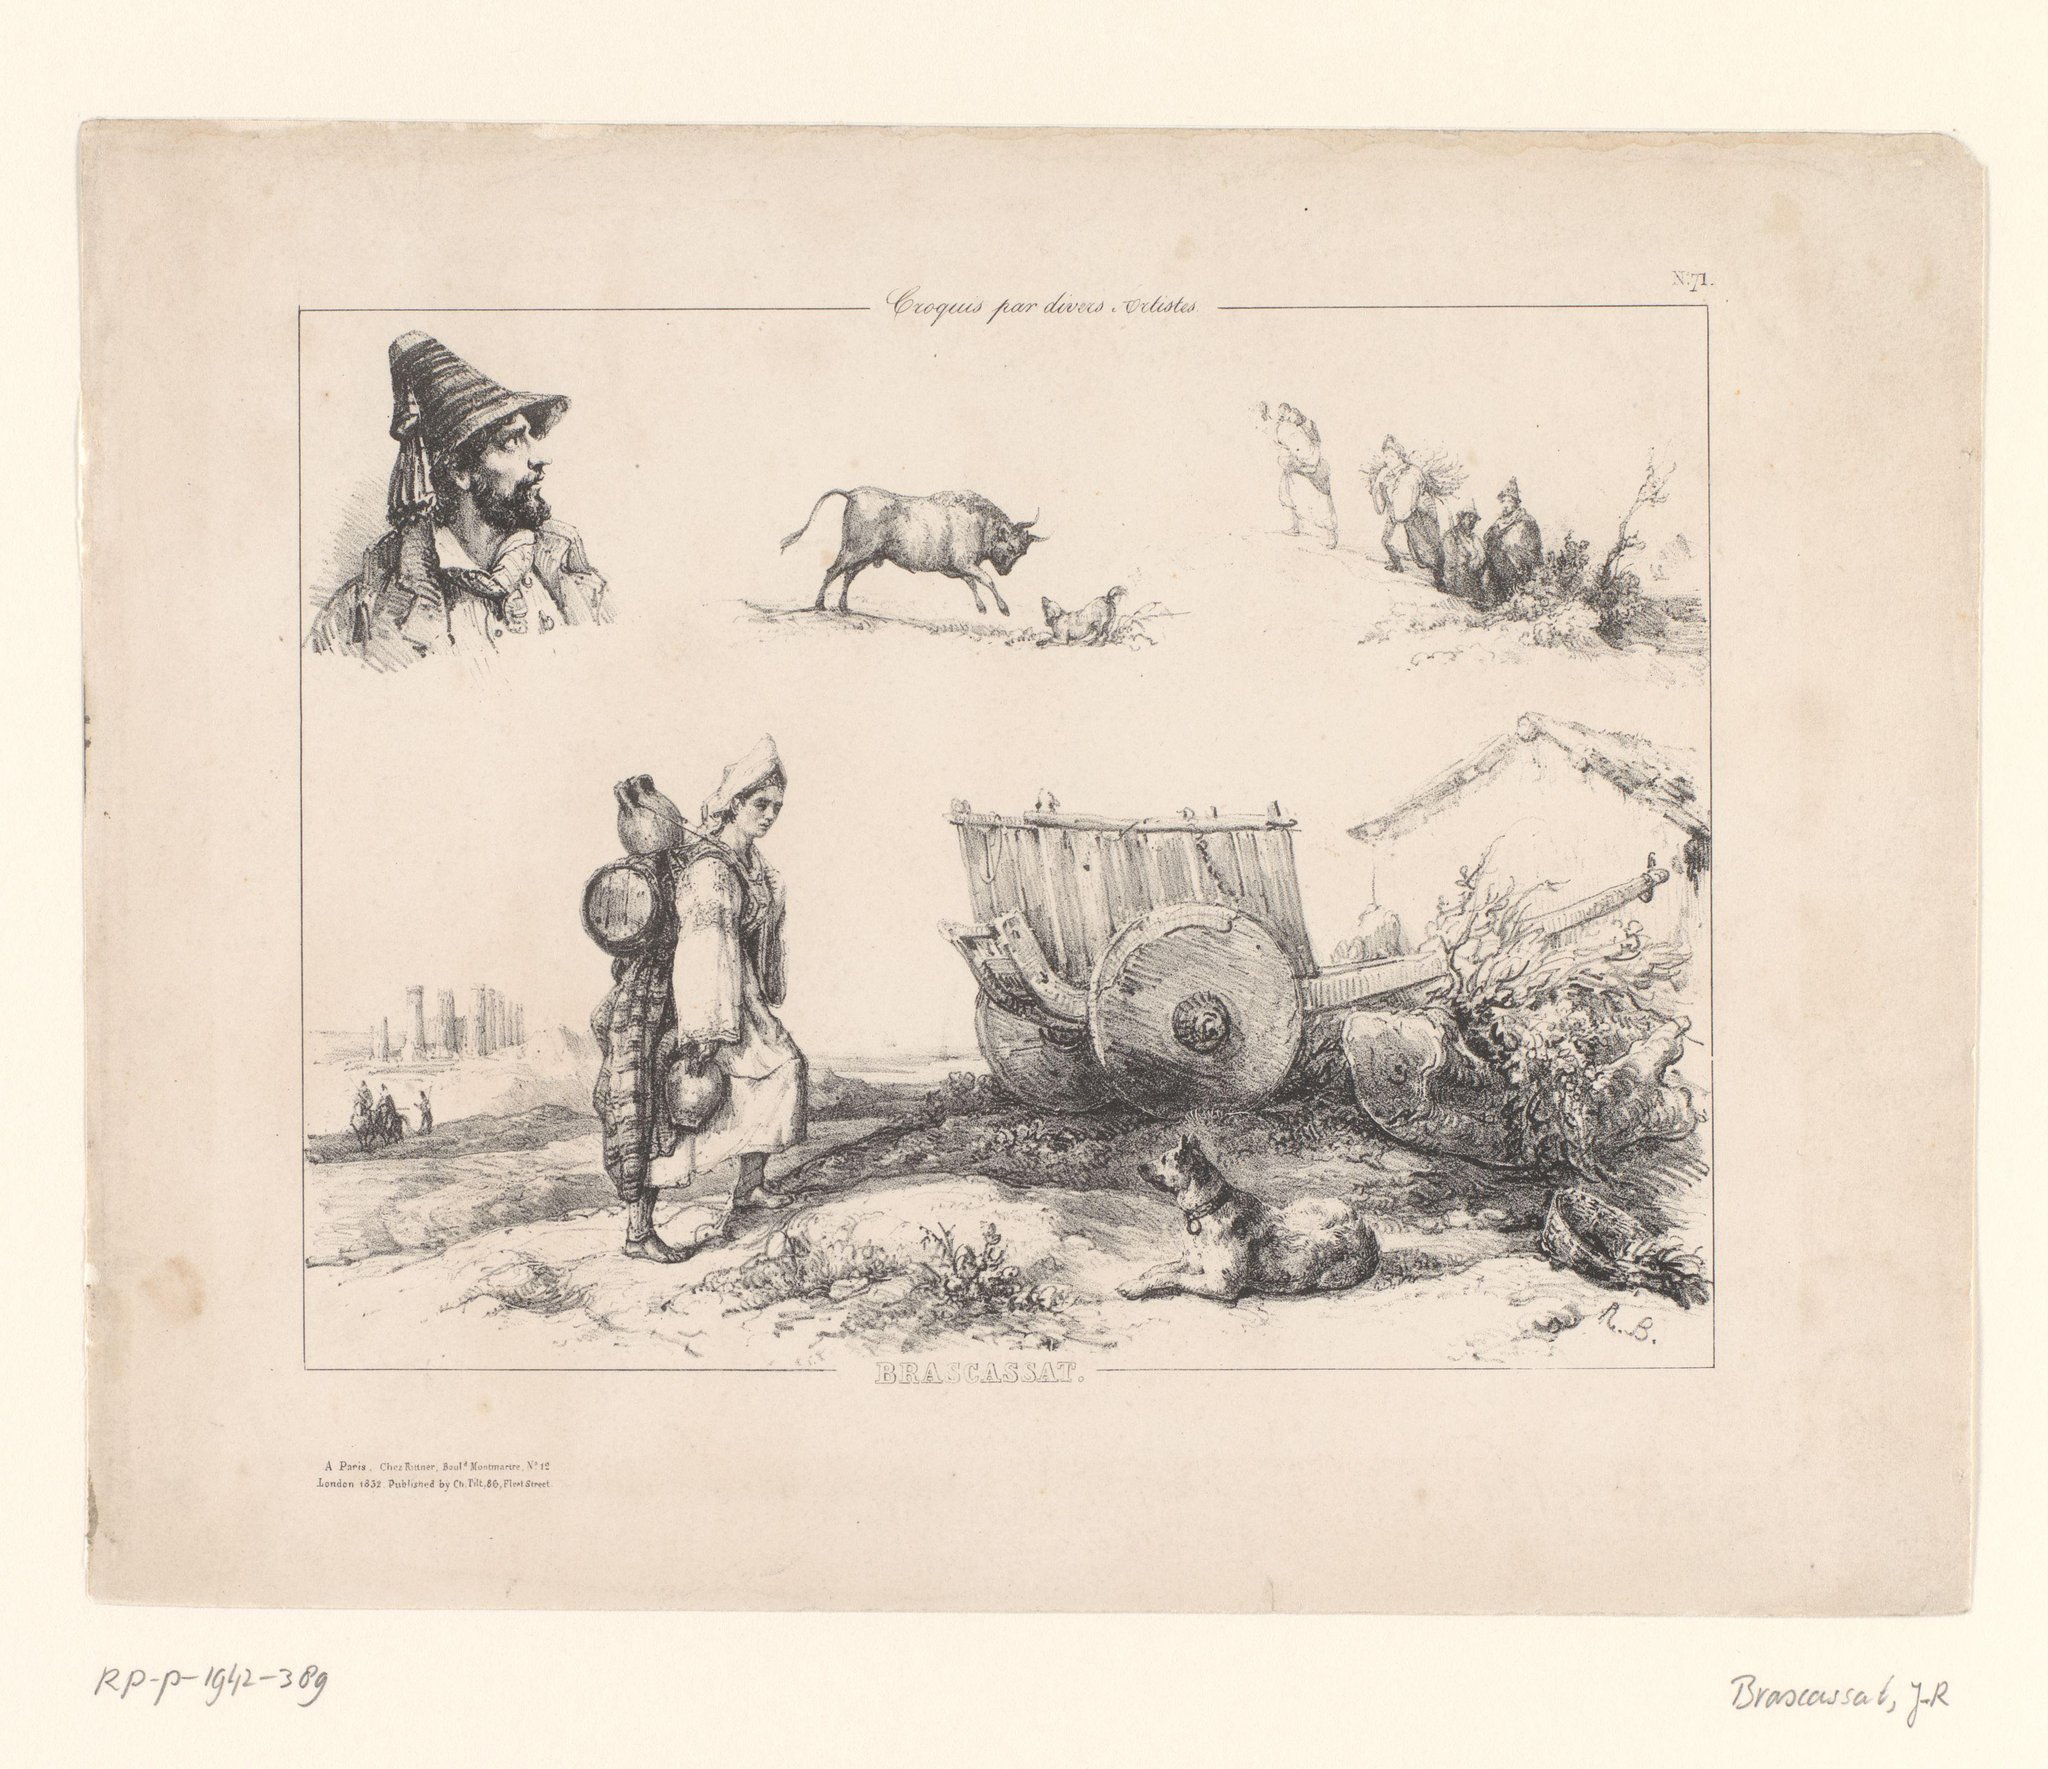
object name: print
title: Vier voorstellingen van mensen en dieren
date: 1832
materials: paper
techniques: lithograph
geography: paris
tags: (farm) wagon, freight wagon, cart, rural life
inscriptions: collector's mark: Lugt 2228a, collector's mark: Lugt 2760